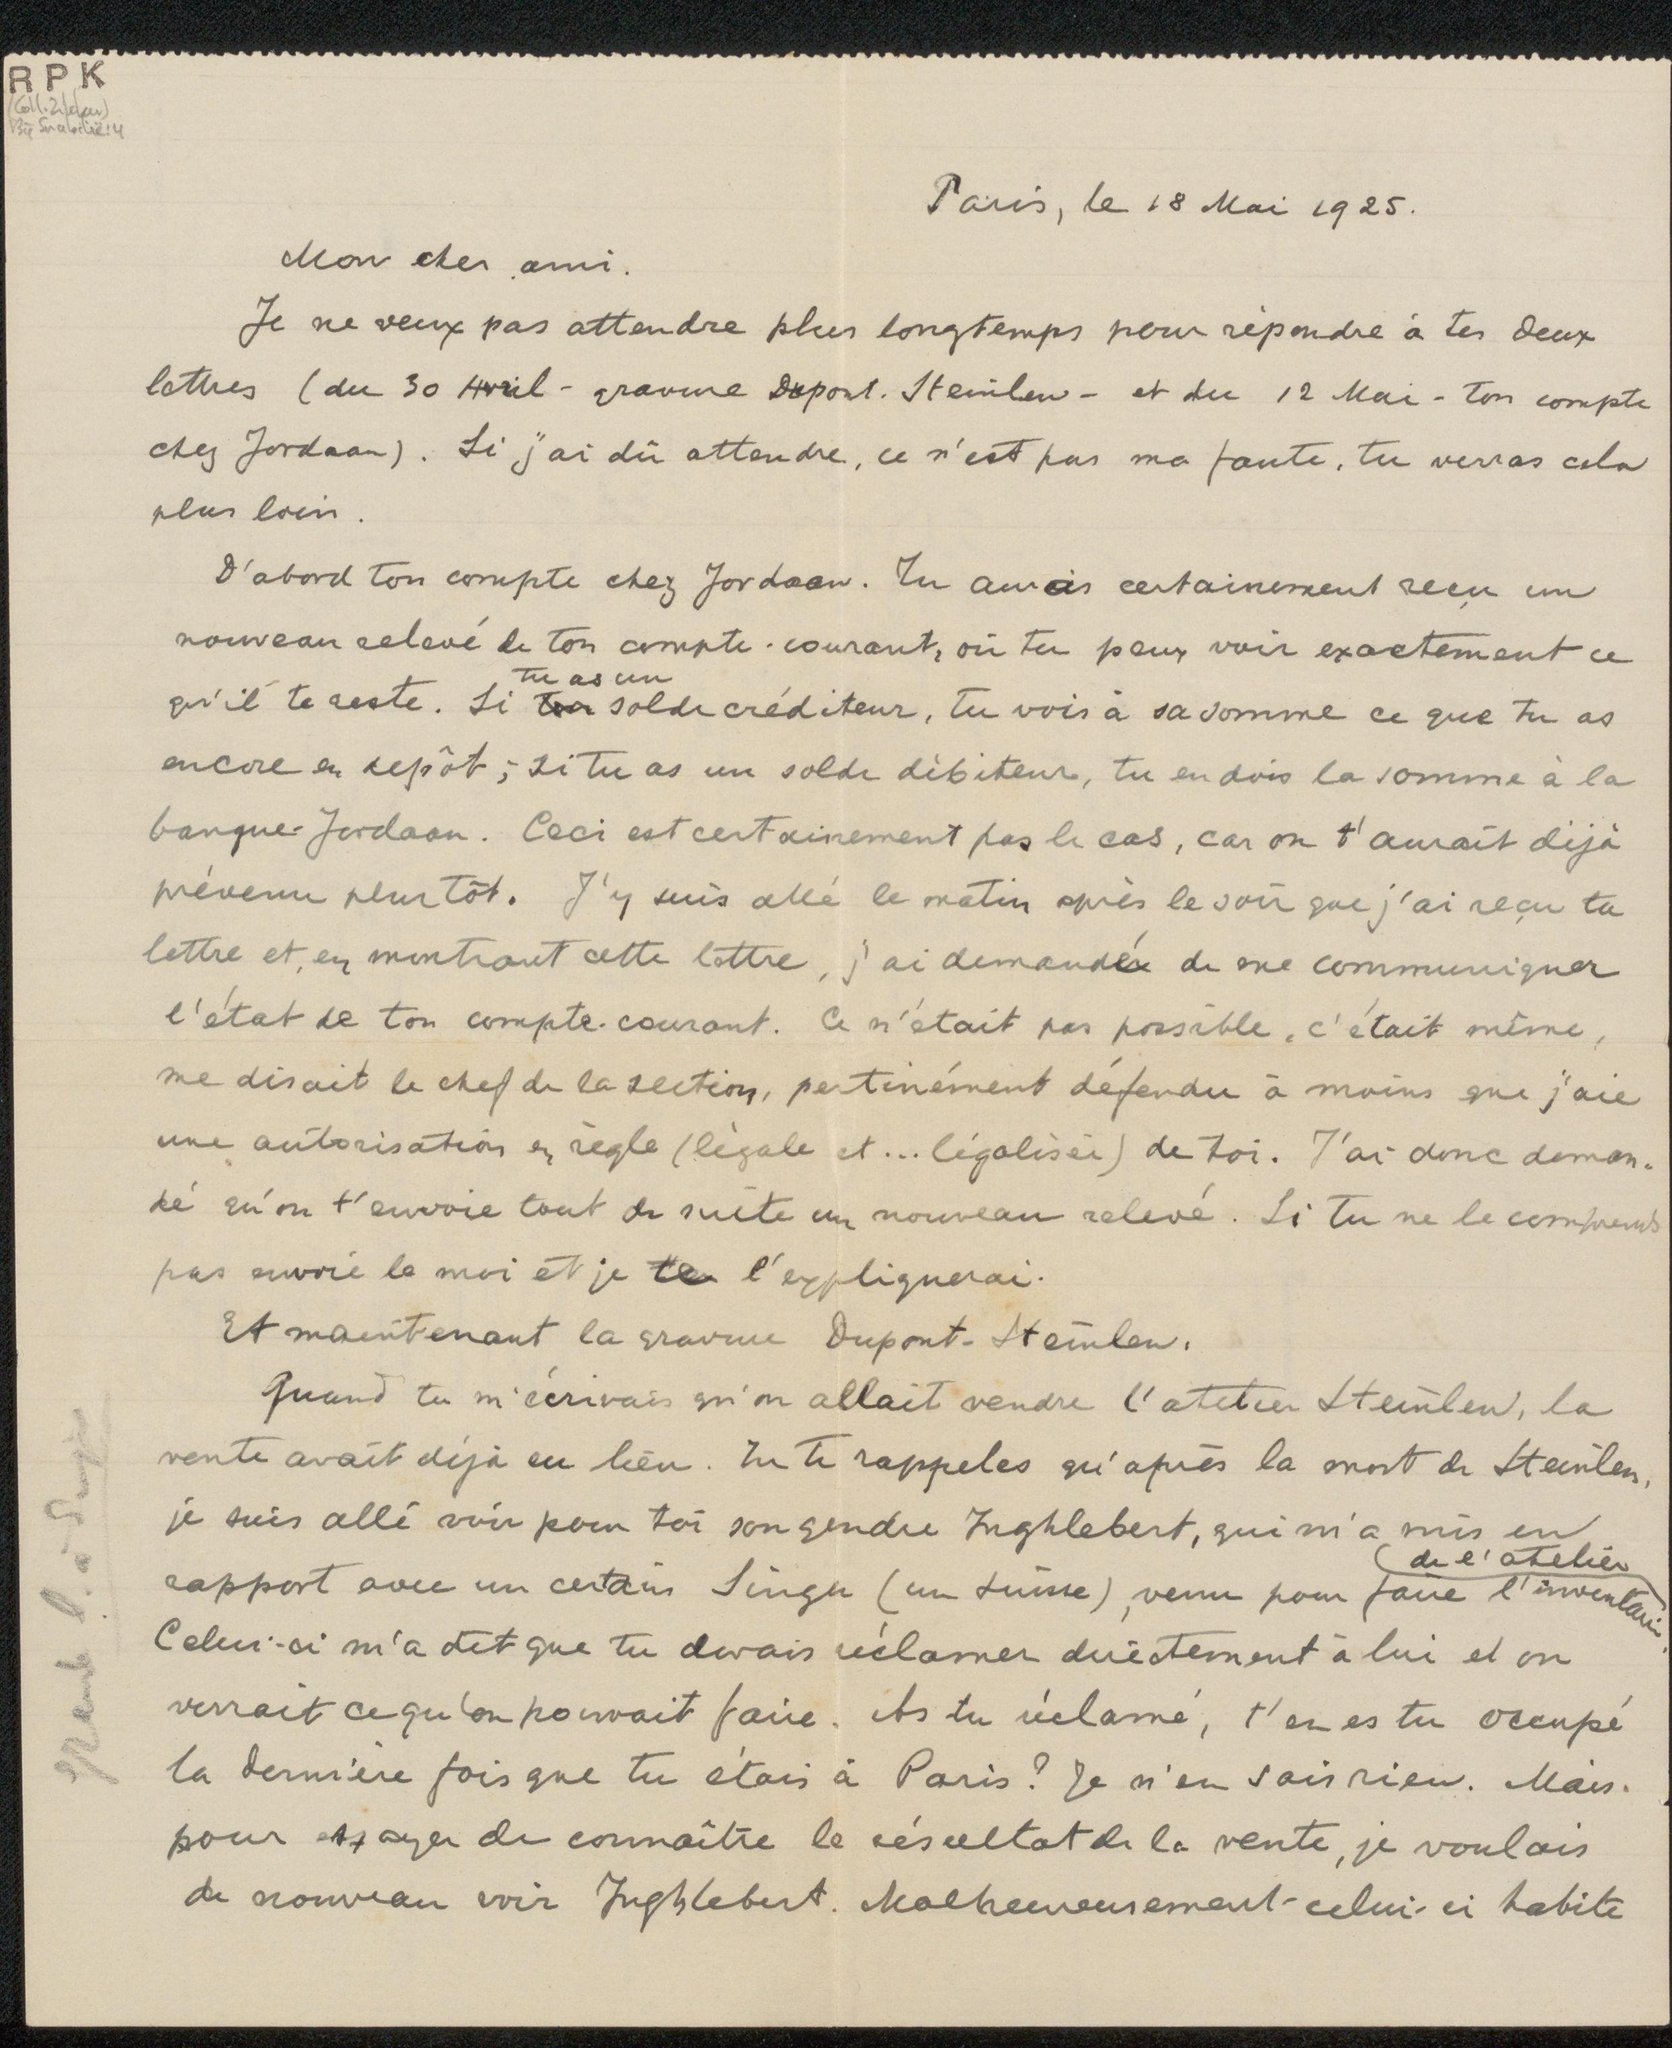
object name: letter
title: Brief aan Philip Zilcken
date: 1925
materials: ink, pencil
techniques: pen, writing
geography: paris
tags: middelburg, paris, print maker, isodoor boasson, sculptor, théophile alexandre steinlen, amsterdam, pieter dupont, rose imel, painter, draughtsman, philip zilcken, photography, cinematography, the graphic arts, workshop, studio of the artist (in general), money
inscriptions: address: ‘CH. SNABILIÉ/ 19, Rue Carpeaux/ PARIS (18e)’, collector's mark: ‘RPK’